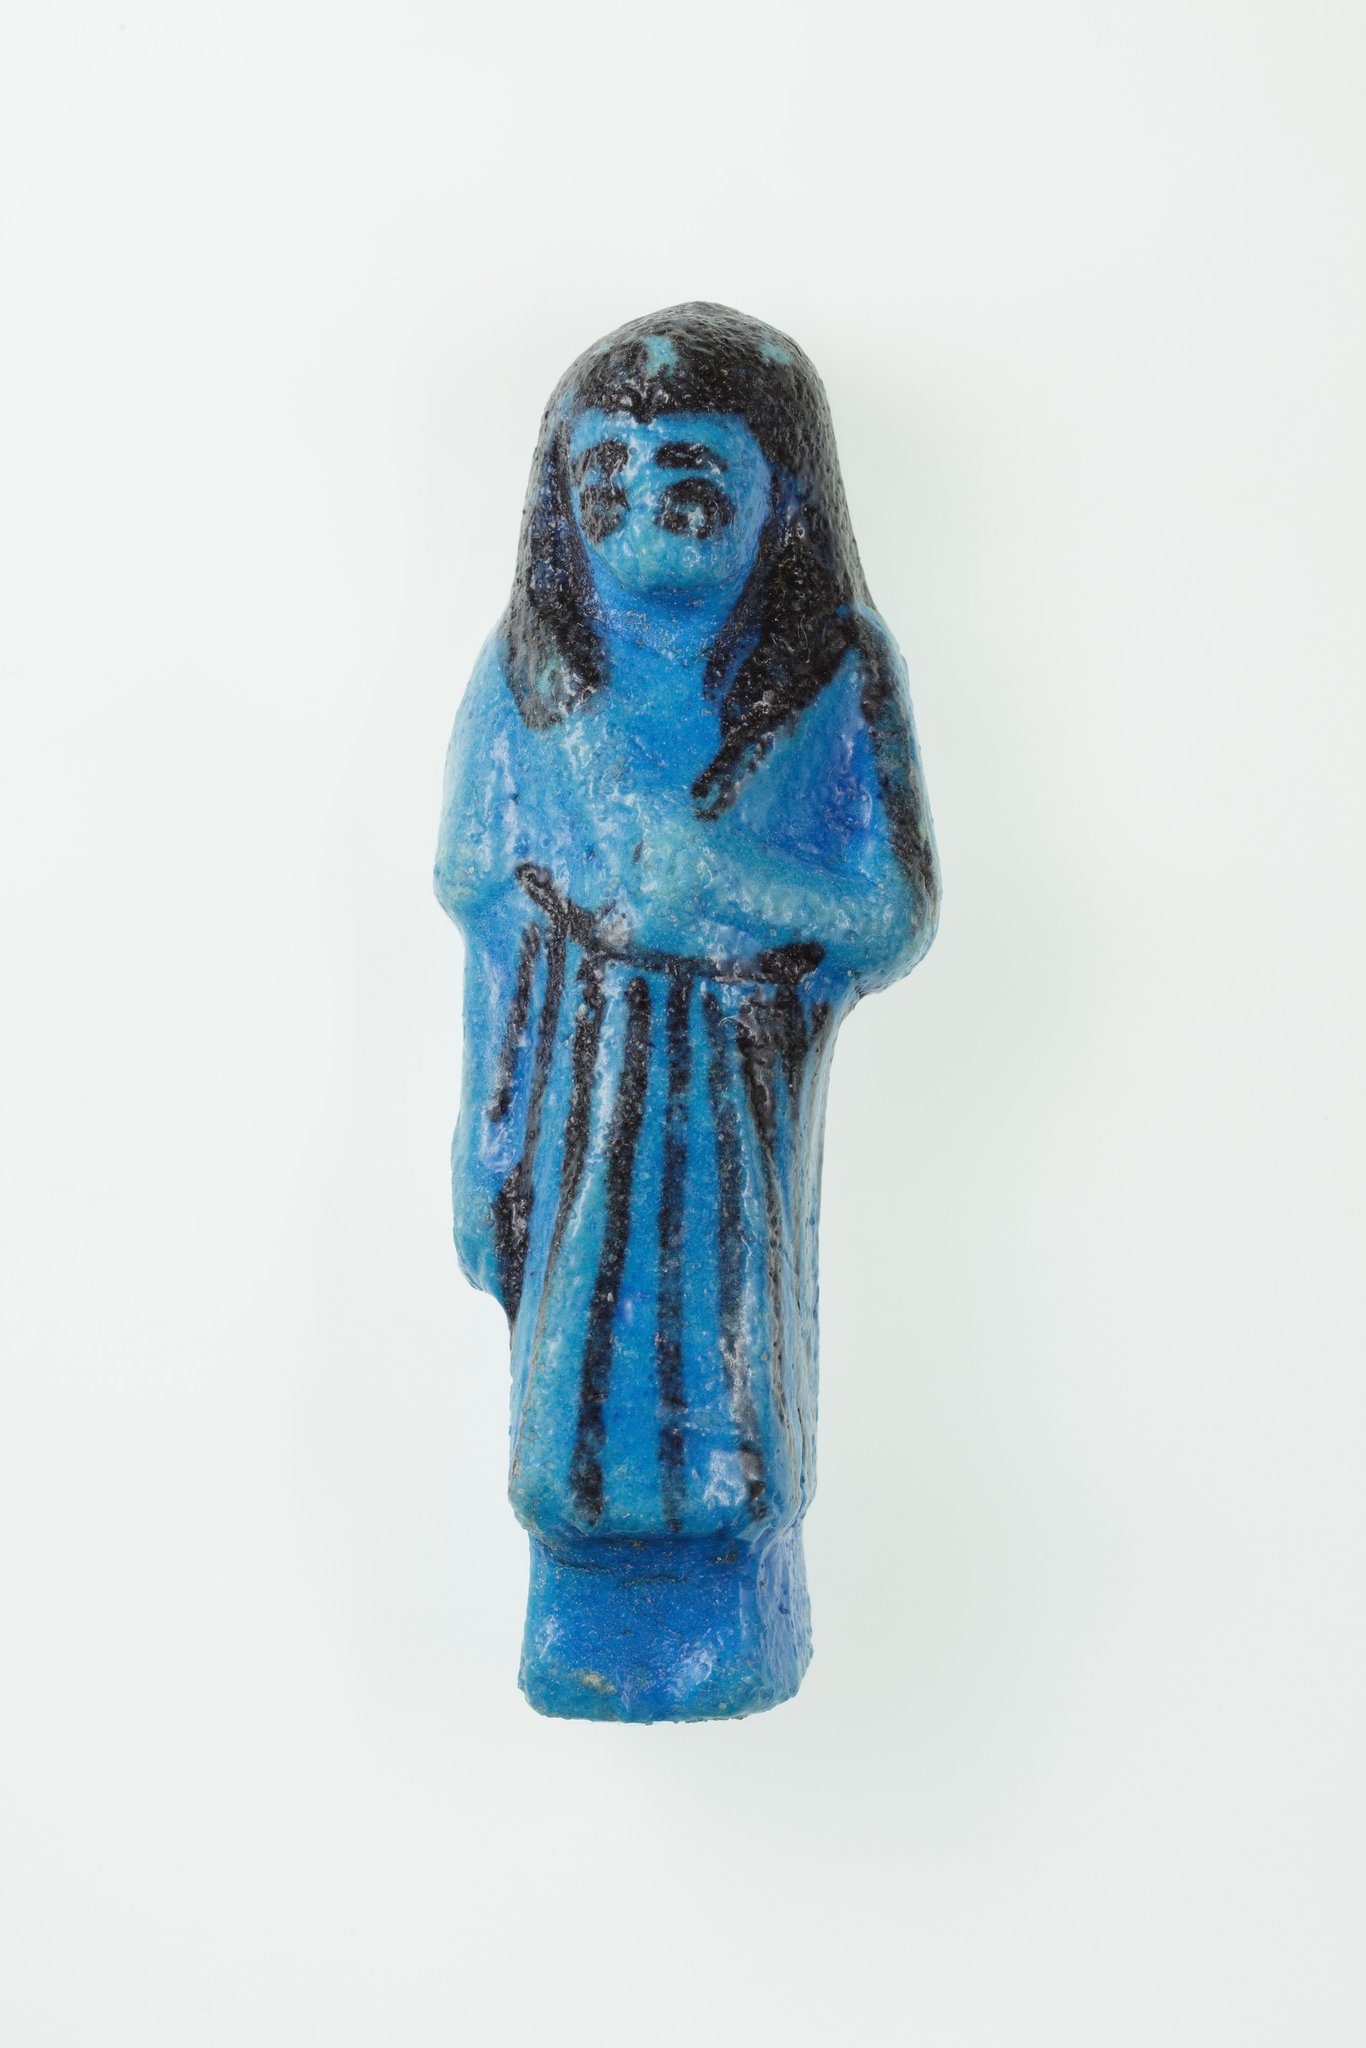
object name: shabti, overseer, nauny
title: Overseer Shabti of Nauny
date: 1050 BCE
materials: faience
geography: egypt